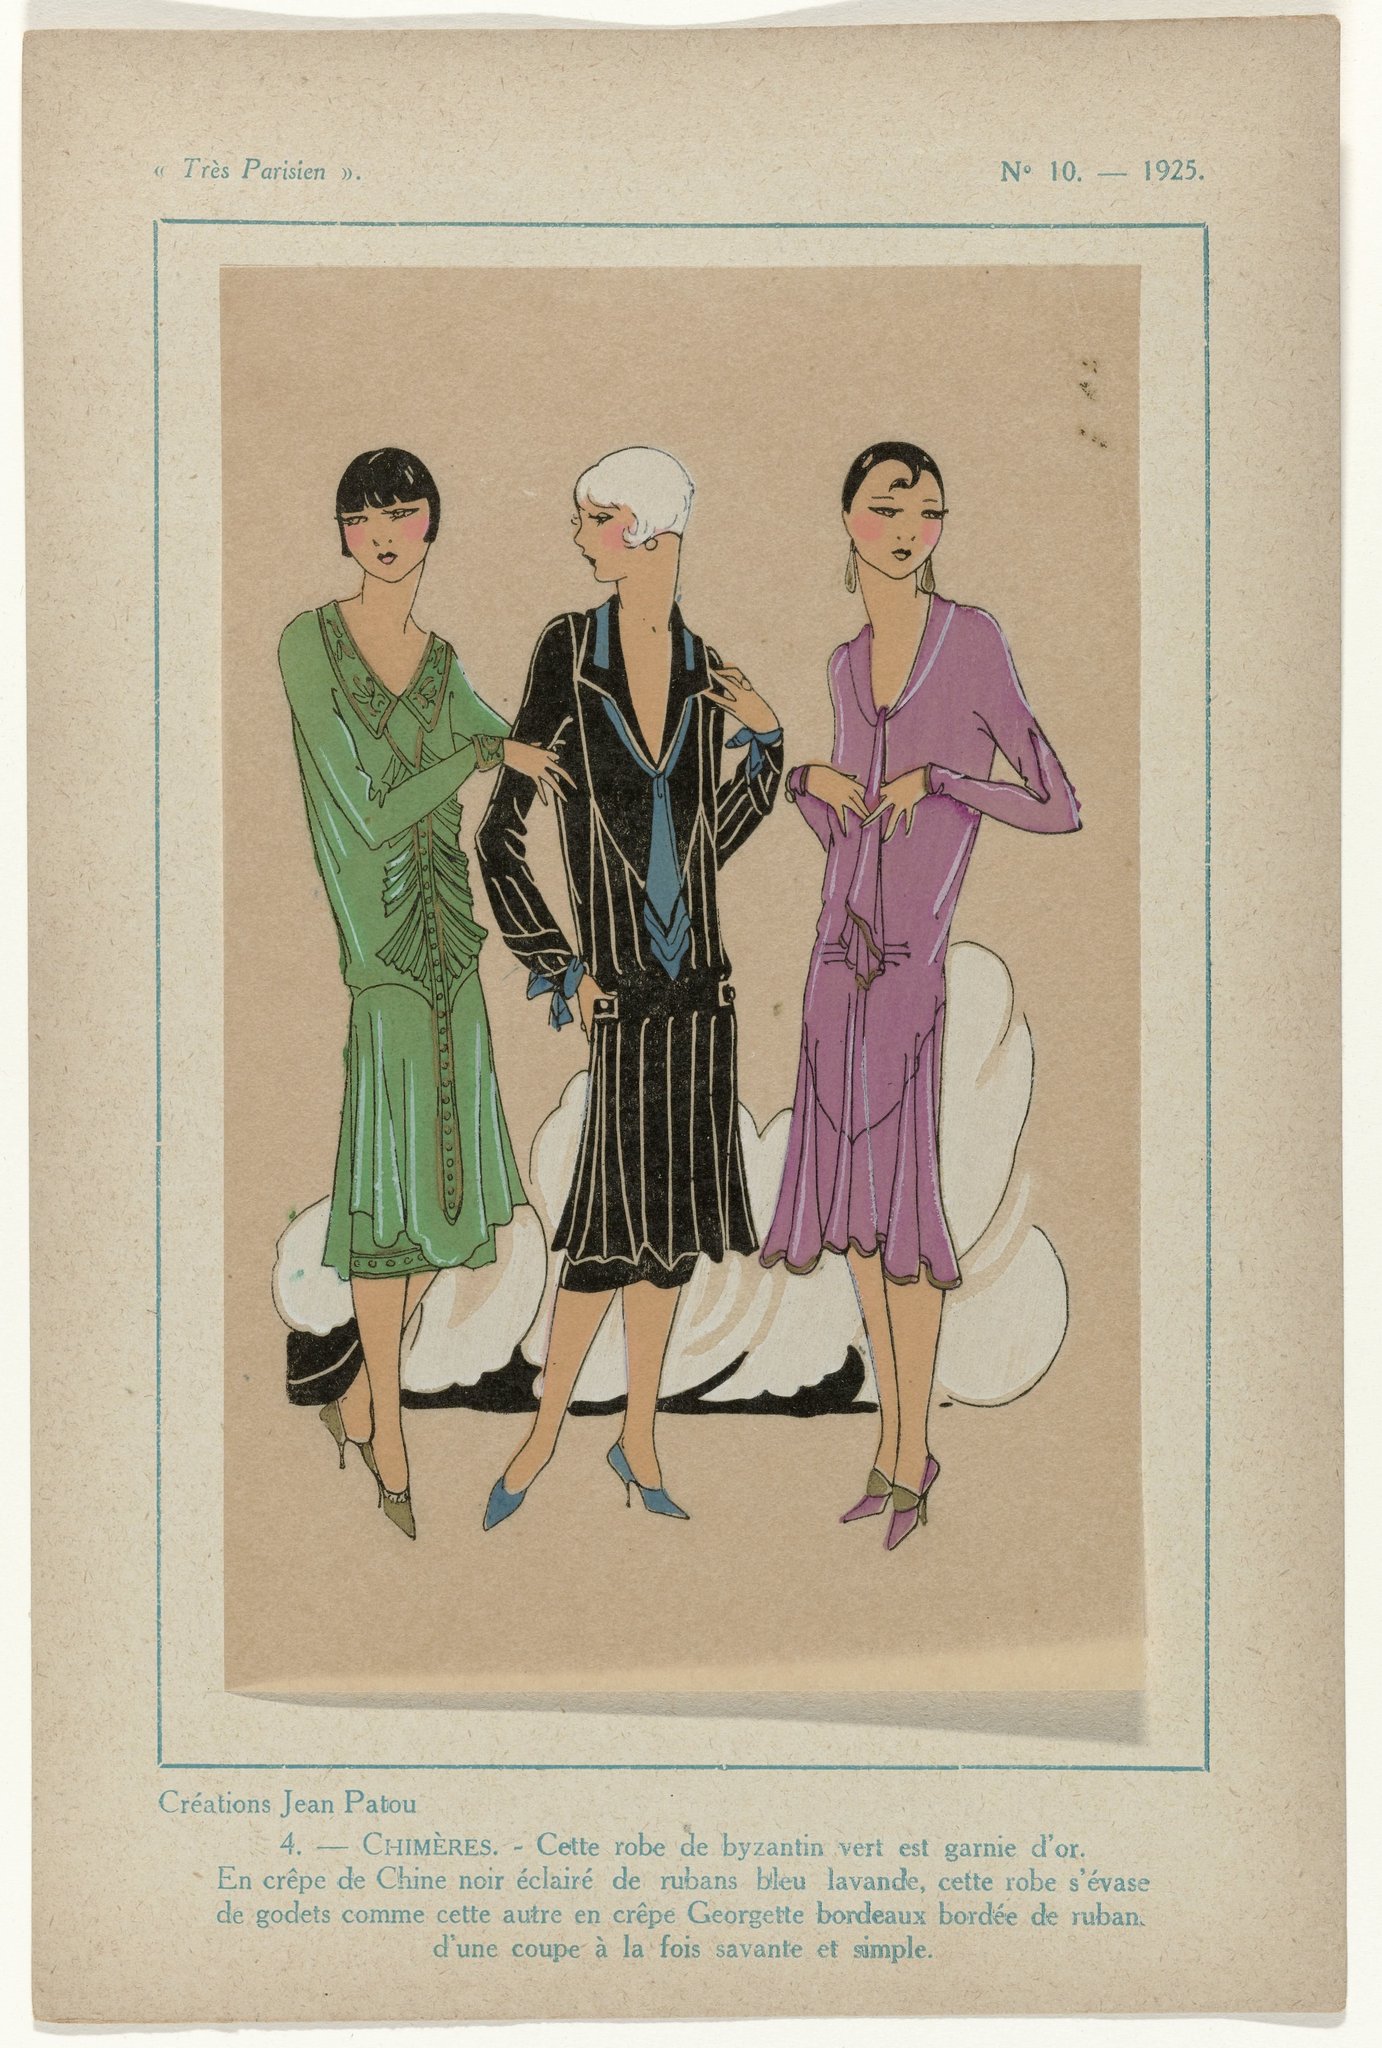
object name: fashion print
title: Très Parisien, 1925, No. 10, Pl. 4: Création Jean Patou - CHIMÈRES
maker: g-p. joumard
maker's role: publisher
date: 1925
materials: paper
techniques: hand coloring, letterpress printing, lithography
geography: paris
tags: dress, gown: day dress (+ women's clothes), fashion plates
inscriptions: caption: ‘Cette robe de byzantin vert est garnie d'or. En crêpe de Chine noir éclairé de rubans bleu lavande, cette robe s'évase de godets comme cette autre en crêpe Georgette bordeaux bordée de ruban d'une coupe à la fois savante et simple.’